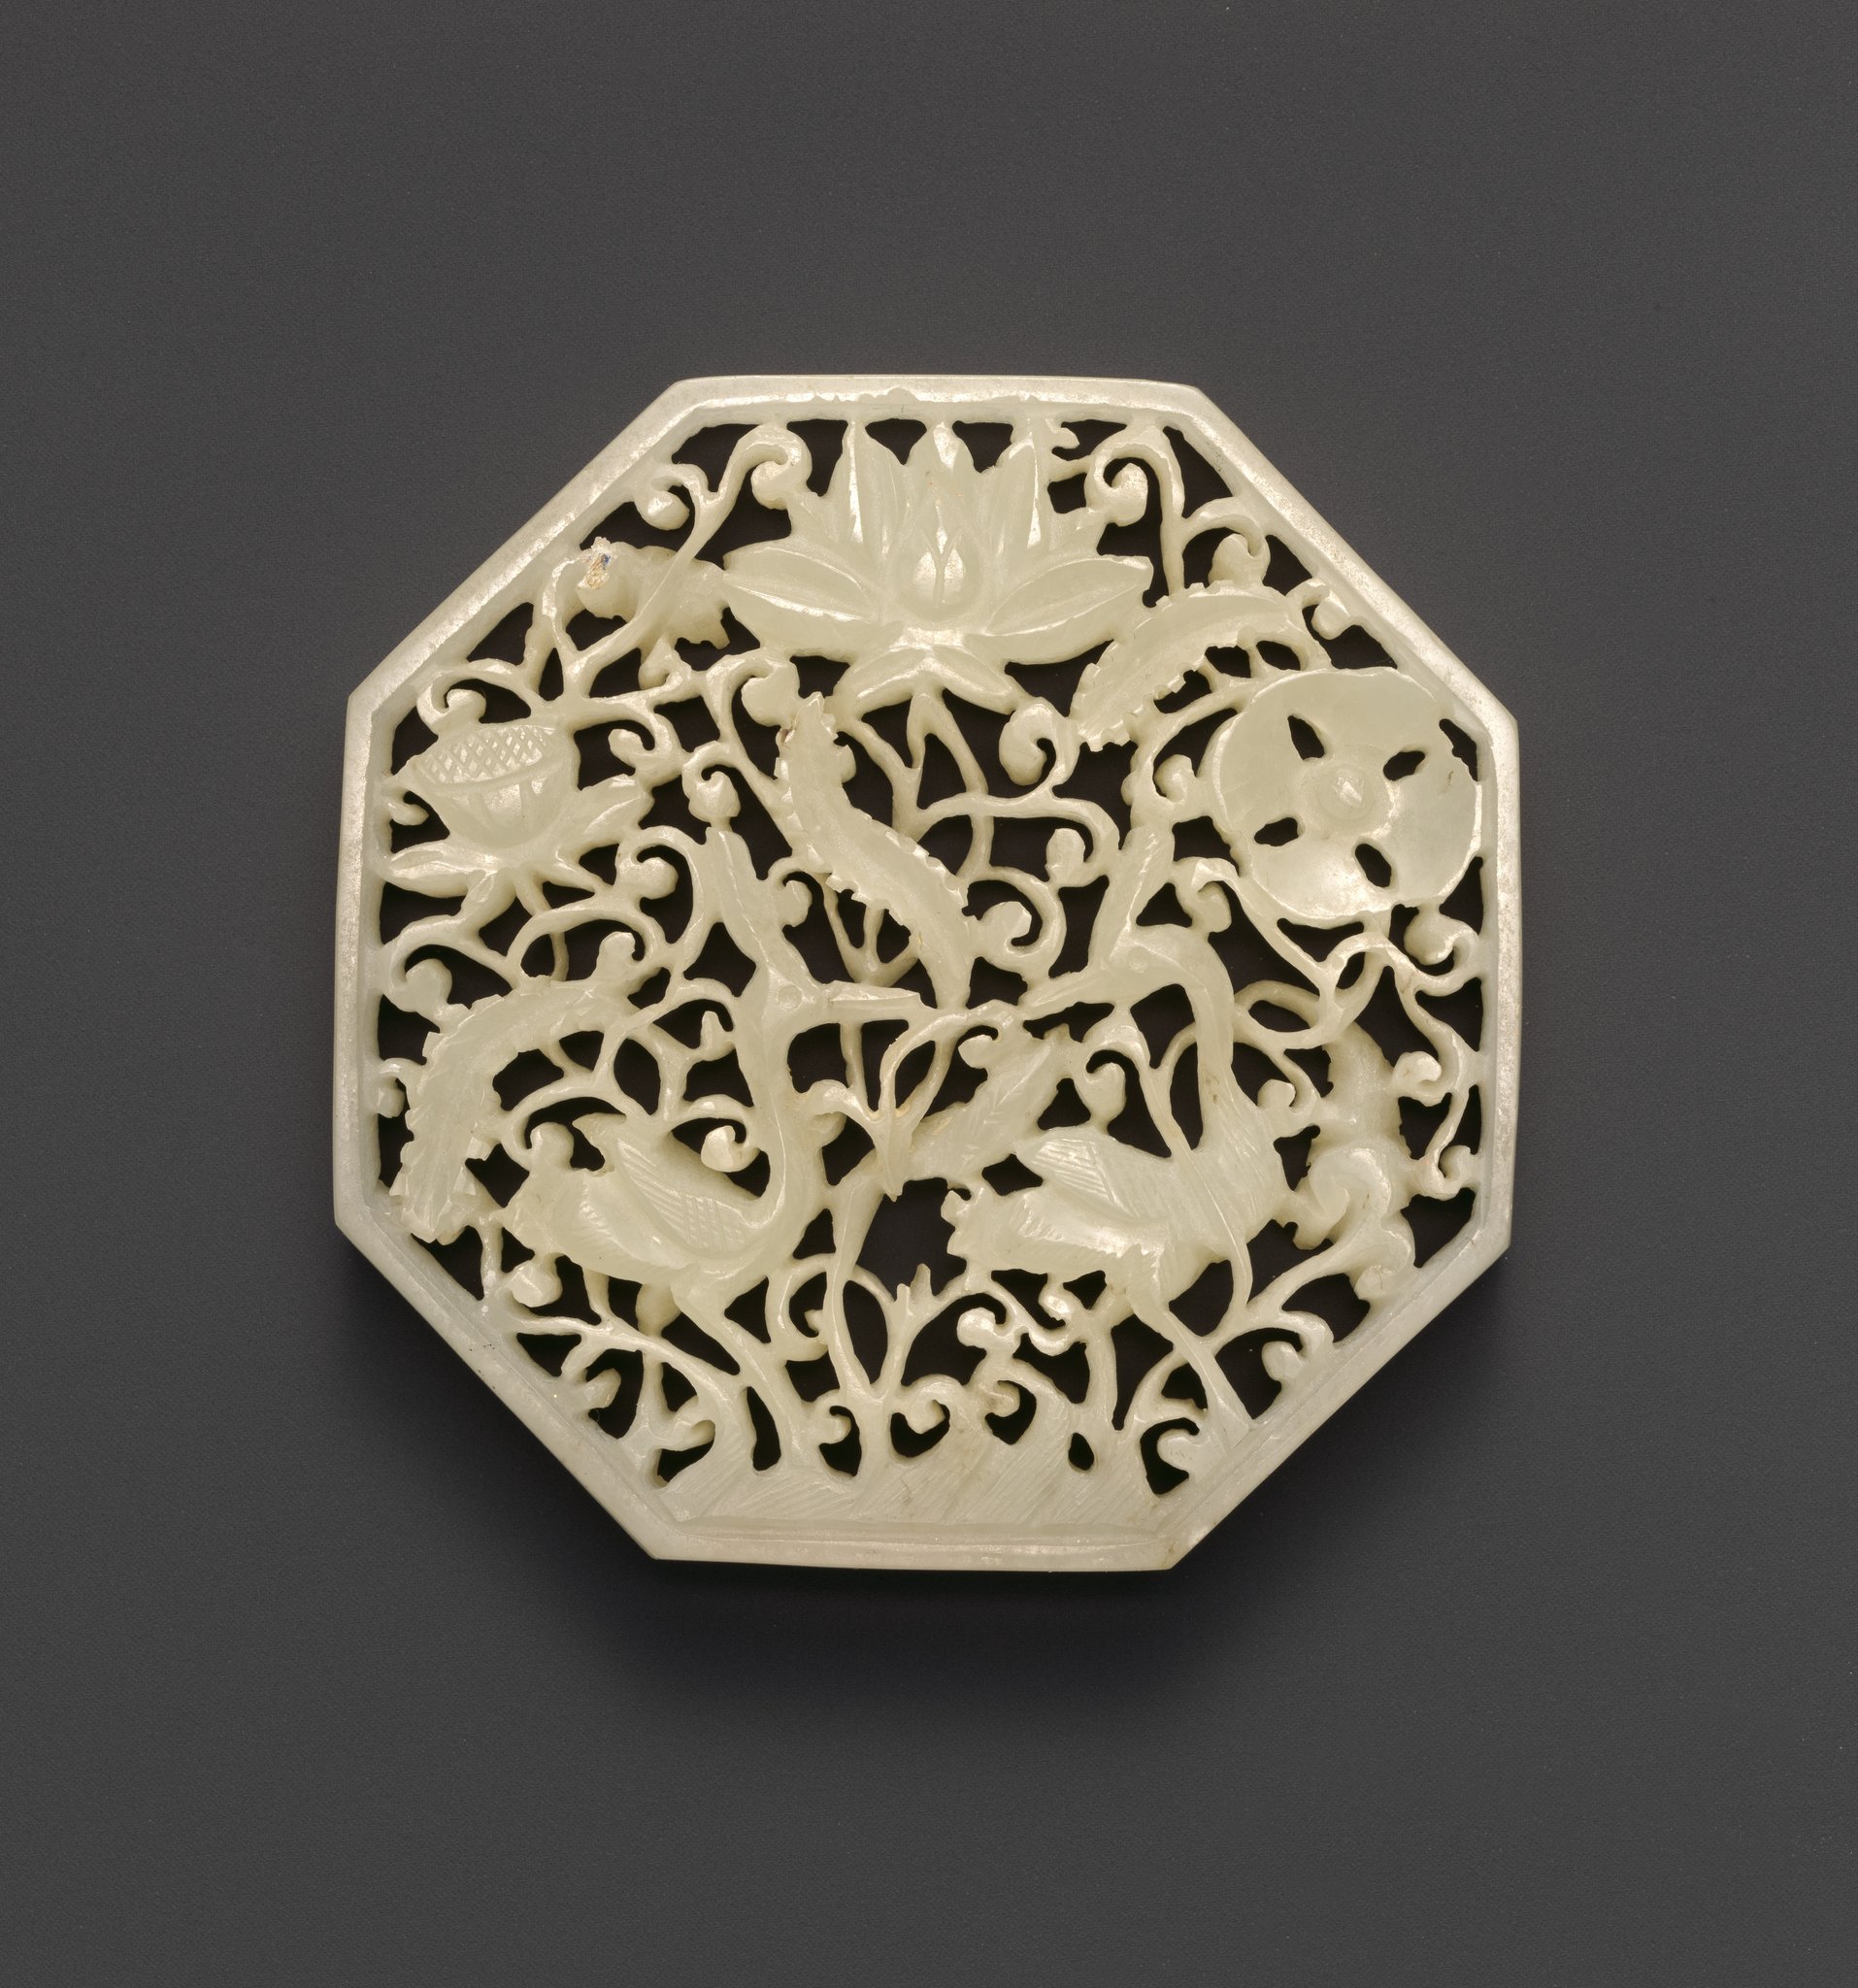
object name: belt plaque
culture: chinese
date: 1501-1600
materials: jade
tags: birds,flowers